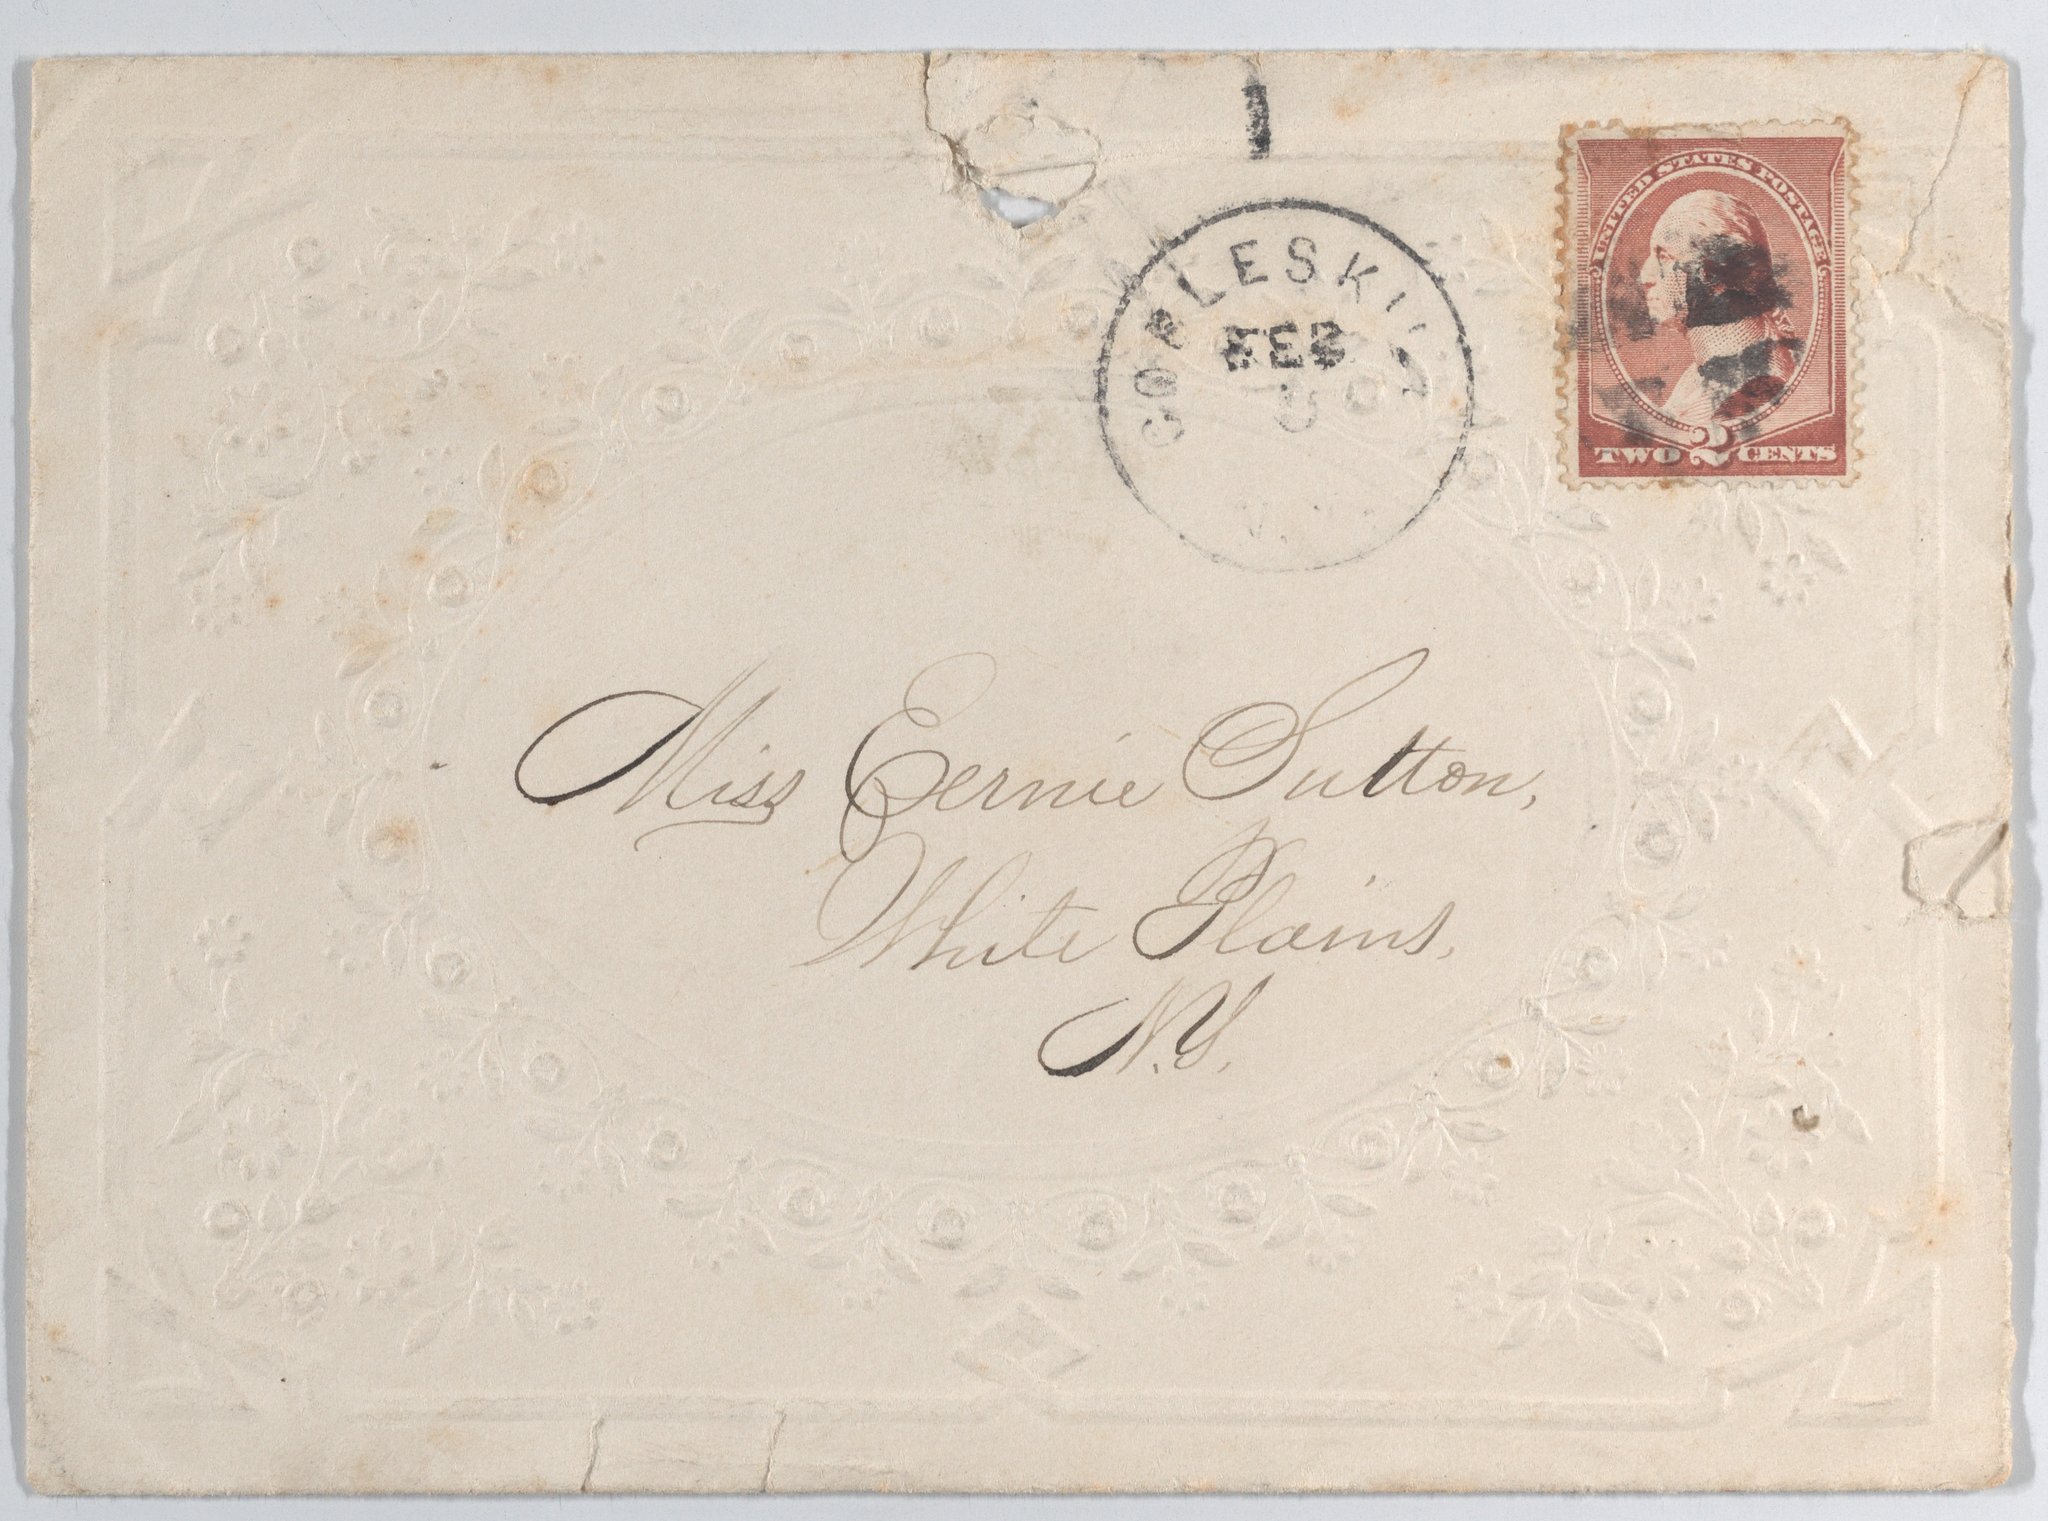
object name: valentine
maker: Anonymous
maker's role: artist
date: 1859-1869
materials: ink, lace, paper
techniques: chromolithography, embossing, open work